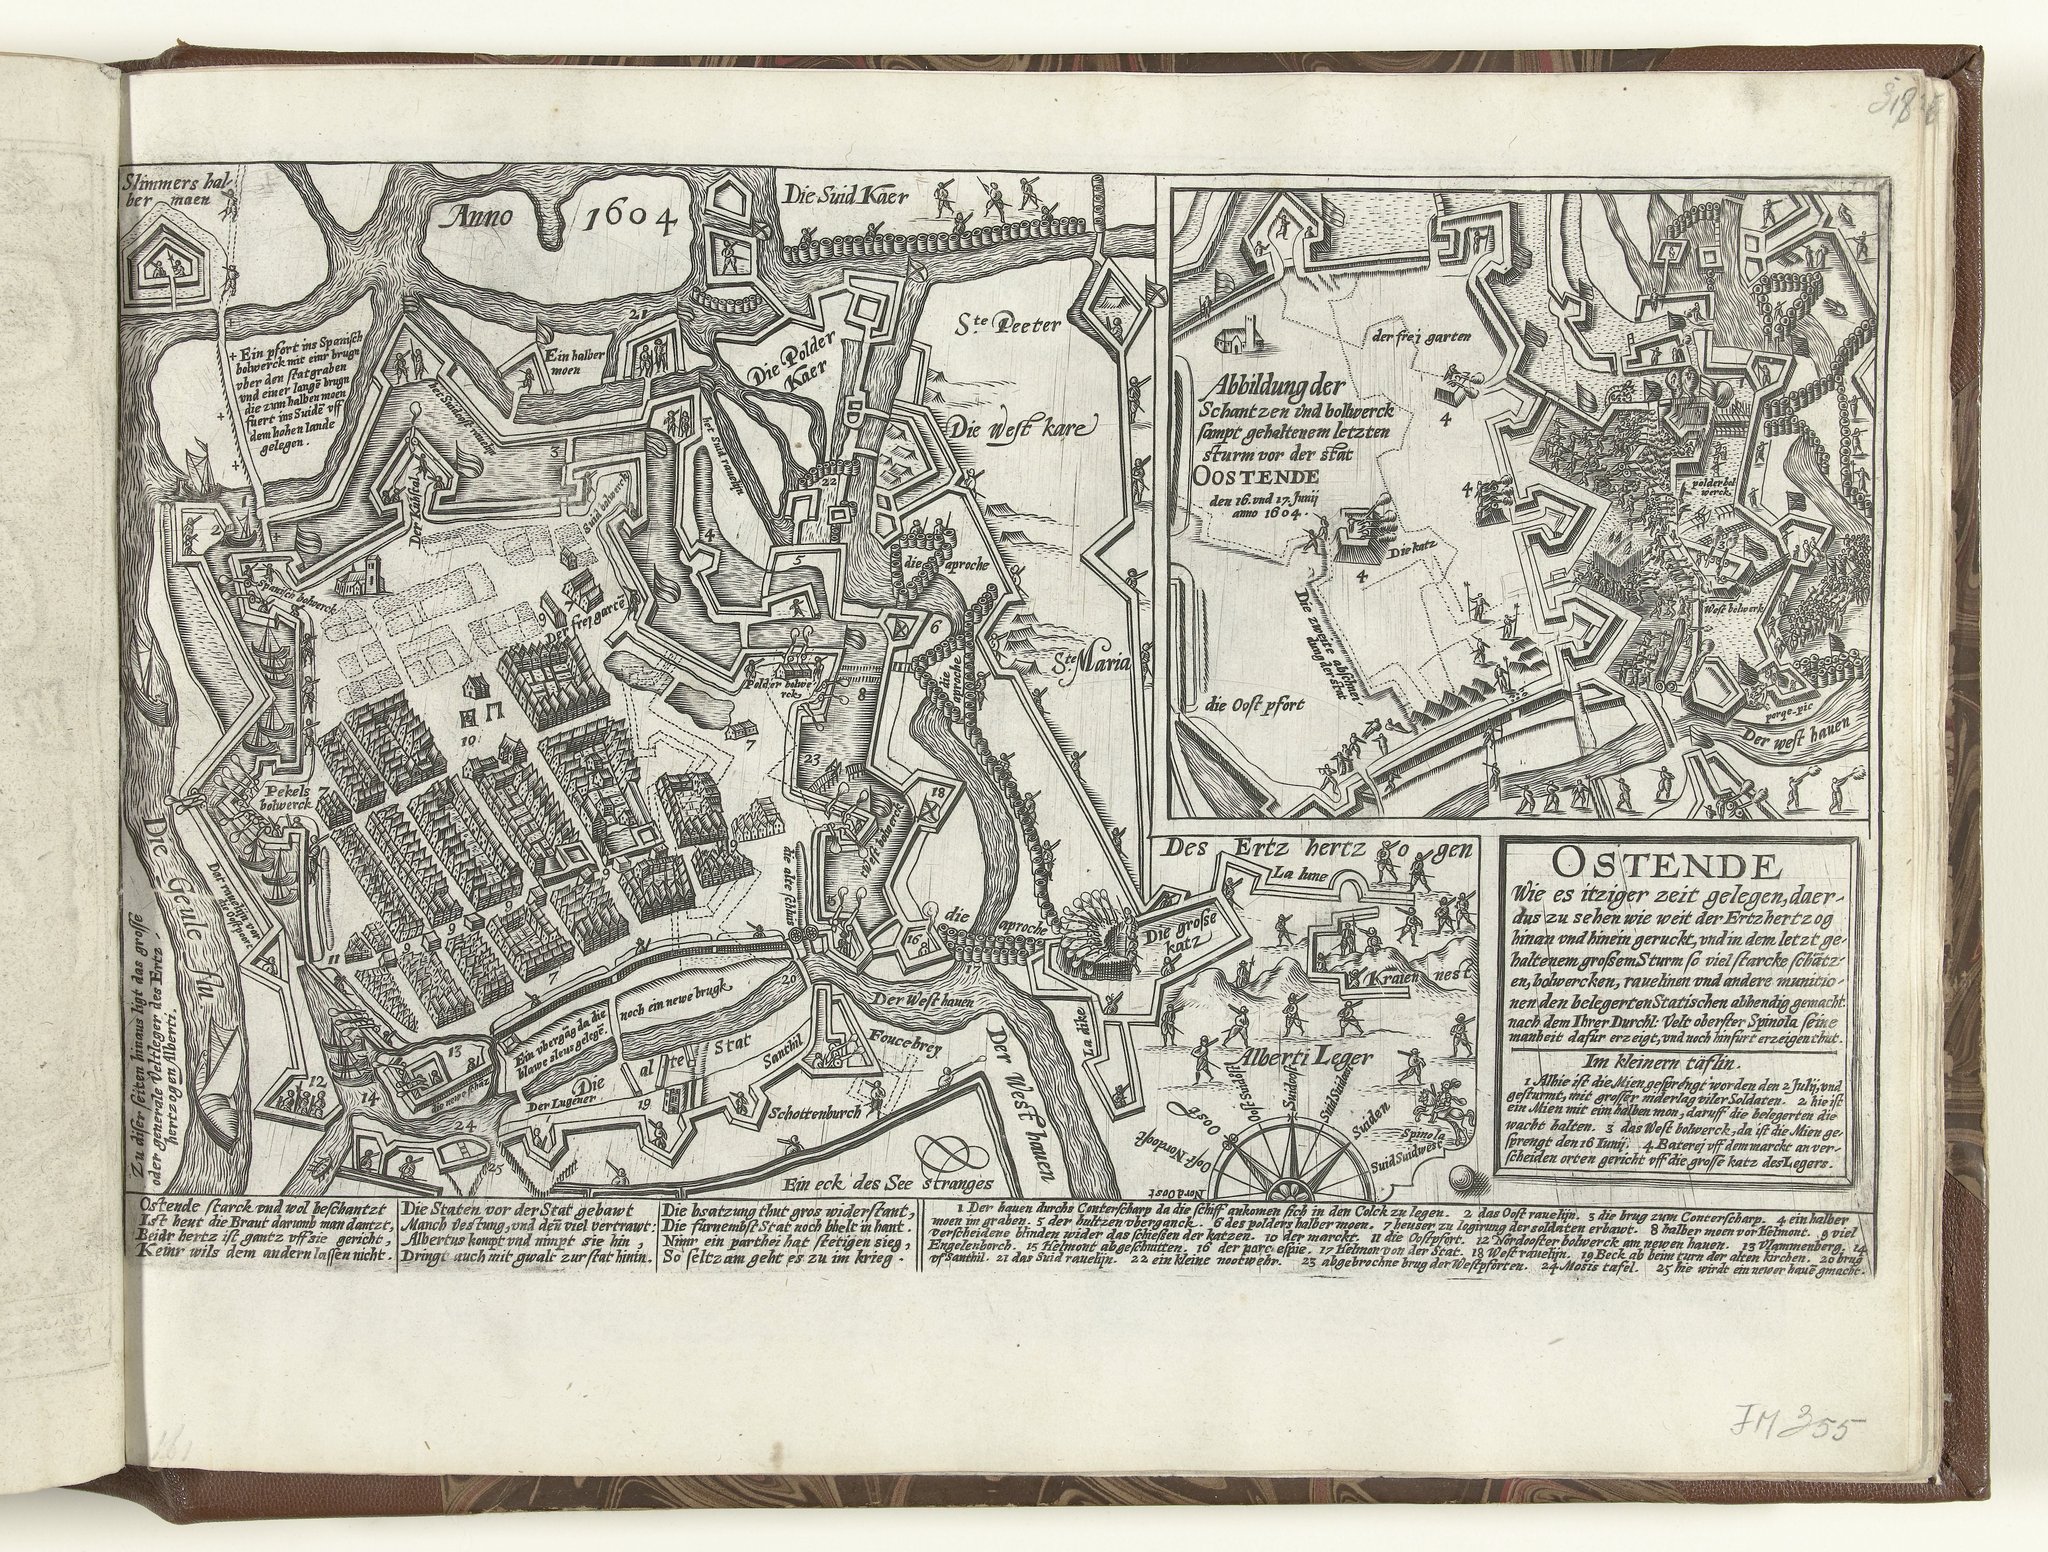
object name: print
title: Serie 10: Nederlandse en Buitenlandse Gebeurtenissen, 1587-1612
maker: frans hogenberg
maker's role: print maker, publisher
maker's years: 1538-1590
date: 1604-1606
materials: paper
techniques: engraving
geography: cologne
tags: the hague, maurice (prince of orange), brussels, albrecht aartshertog van oostenrijk, maps of cities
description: Kaart van het belegerde Oostende, juni-juli 1604. Plan van de stad en de posities van de troepen van Albrecht. Inzet met voorstelling van gevechten rond een bolwerk aan de westzijde van de stad op 16-17 juli. Cartouche met titel en tekst. Met onderschrift van 12 regels in het Duits en de legenda van de cijfers 1-25. Ongenummerd.